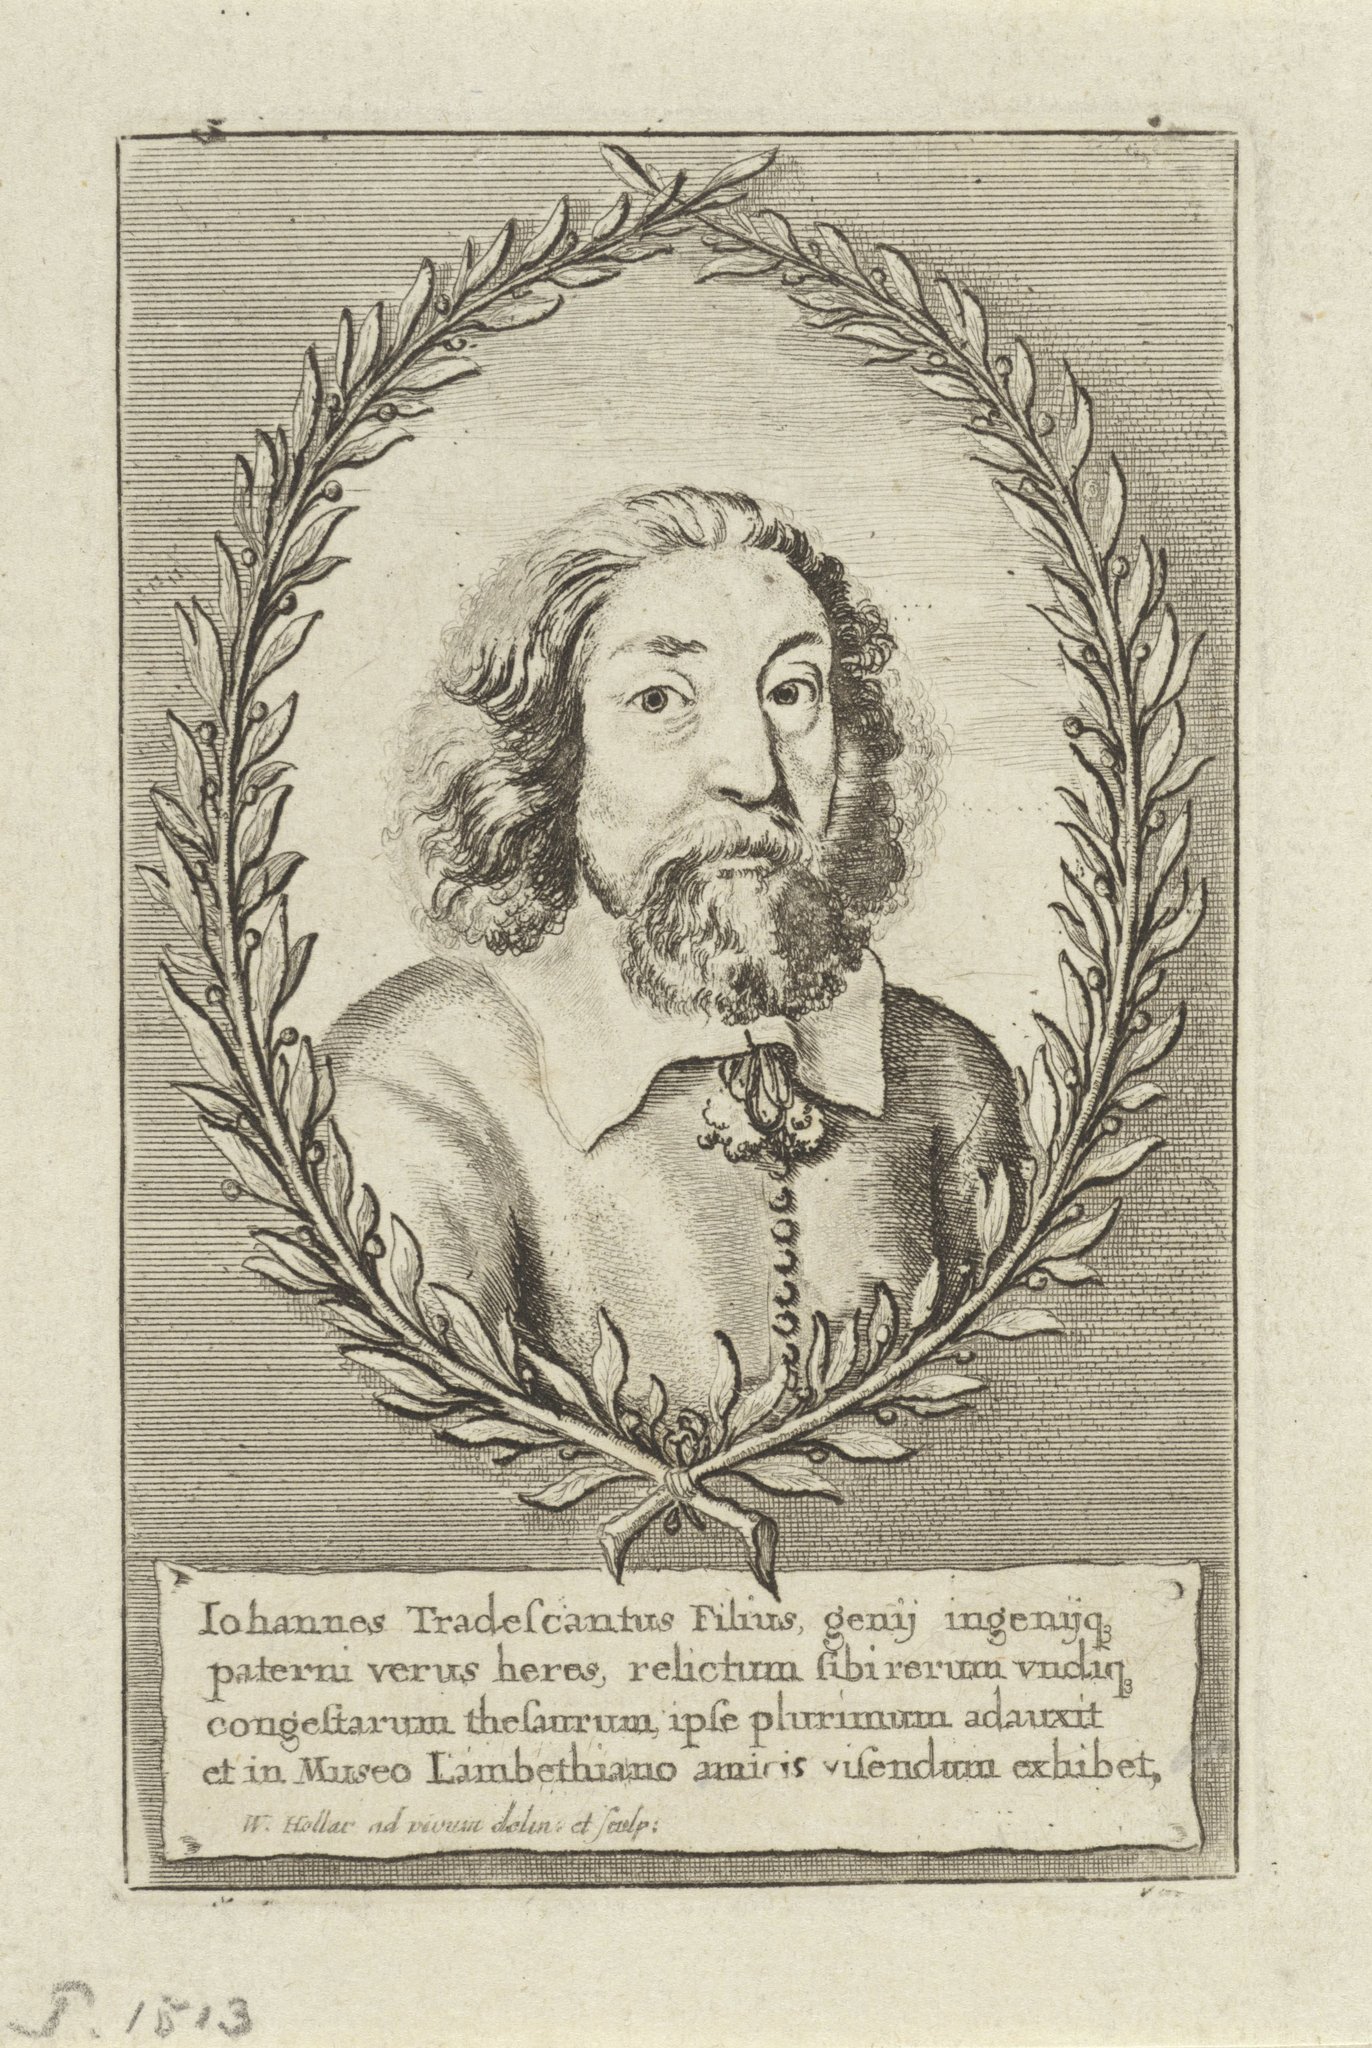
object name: print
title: Portret van John Tradescant de Jonge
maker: wenceslaus hollar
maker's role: draughtsman, print maker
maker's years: 1607-1677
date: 1656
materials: paper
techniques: etching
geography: london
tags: meopham, botanicus, tuinier, john tradescant (ii)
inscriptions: collector's mark: Lugt 2228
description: Portret opgenomen in: Tradescant, John. Musaeum Tradescantianum: Or, A Collection of Rarities Preserved At South-Lambeth, neer London. Printed by John Grismond, 1656.